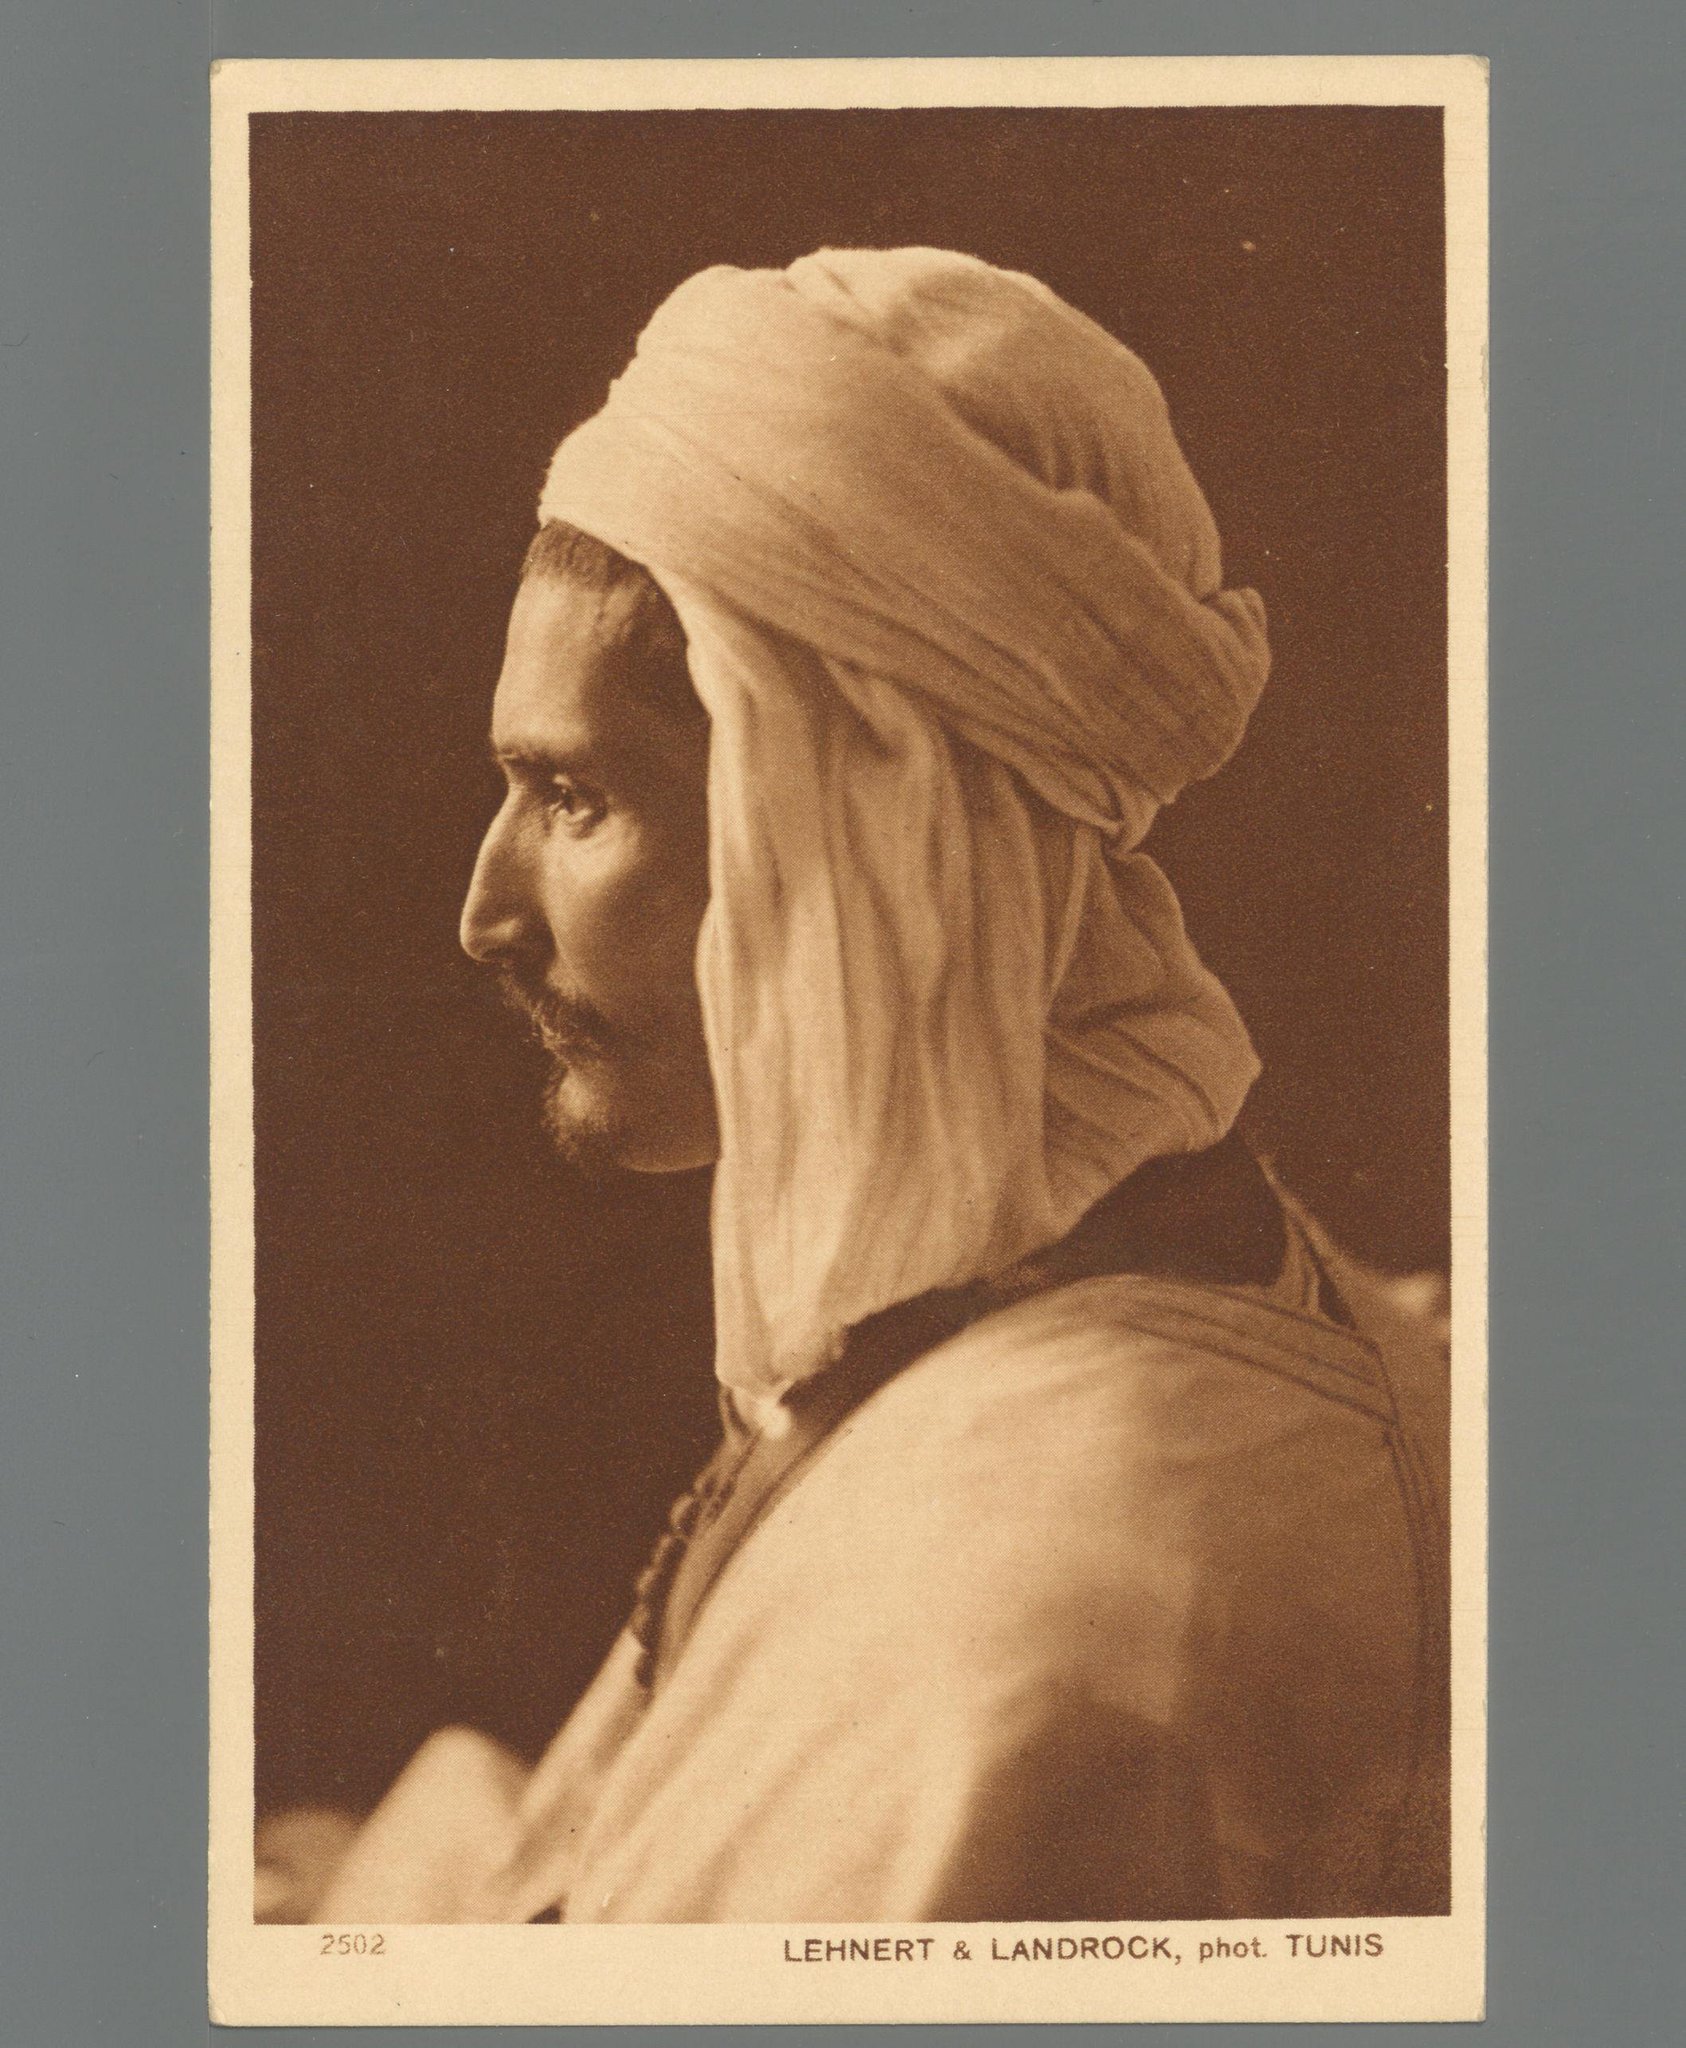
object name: photomechanical print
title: Arabe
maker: Anonymous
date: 1903-1930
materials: cardboard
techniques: rotogravure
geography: tunis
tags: head-gear: turban, historical persons (portraits and scenes from the life)